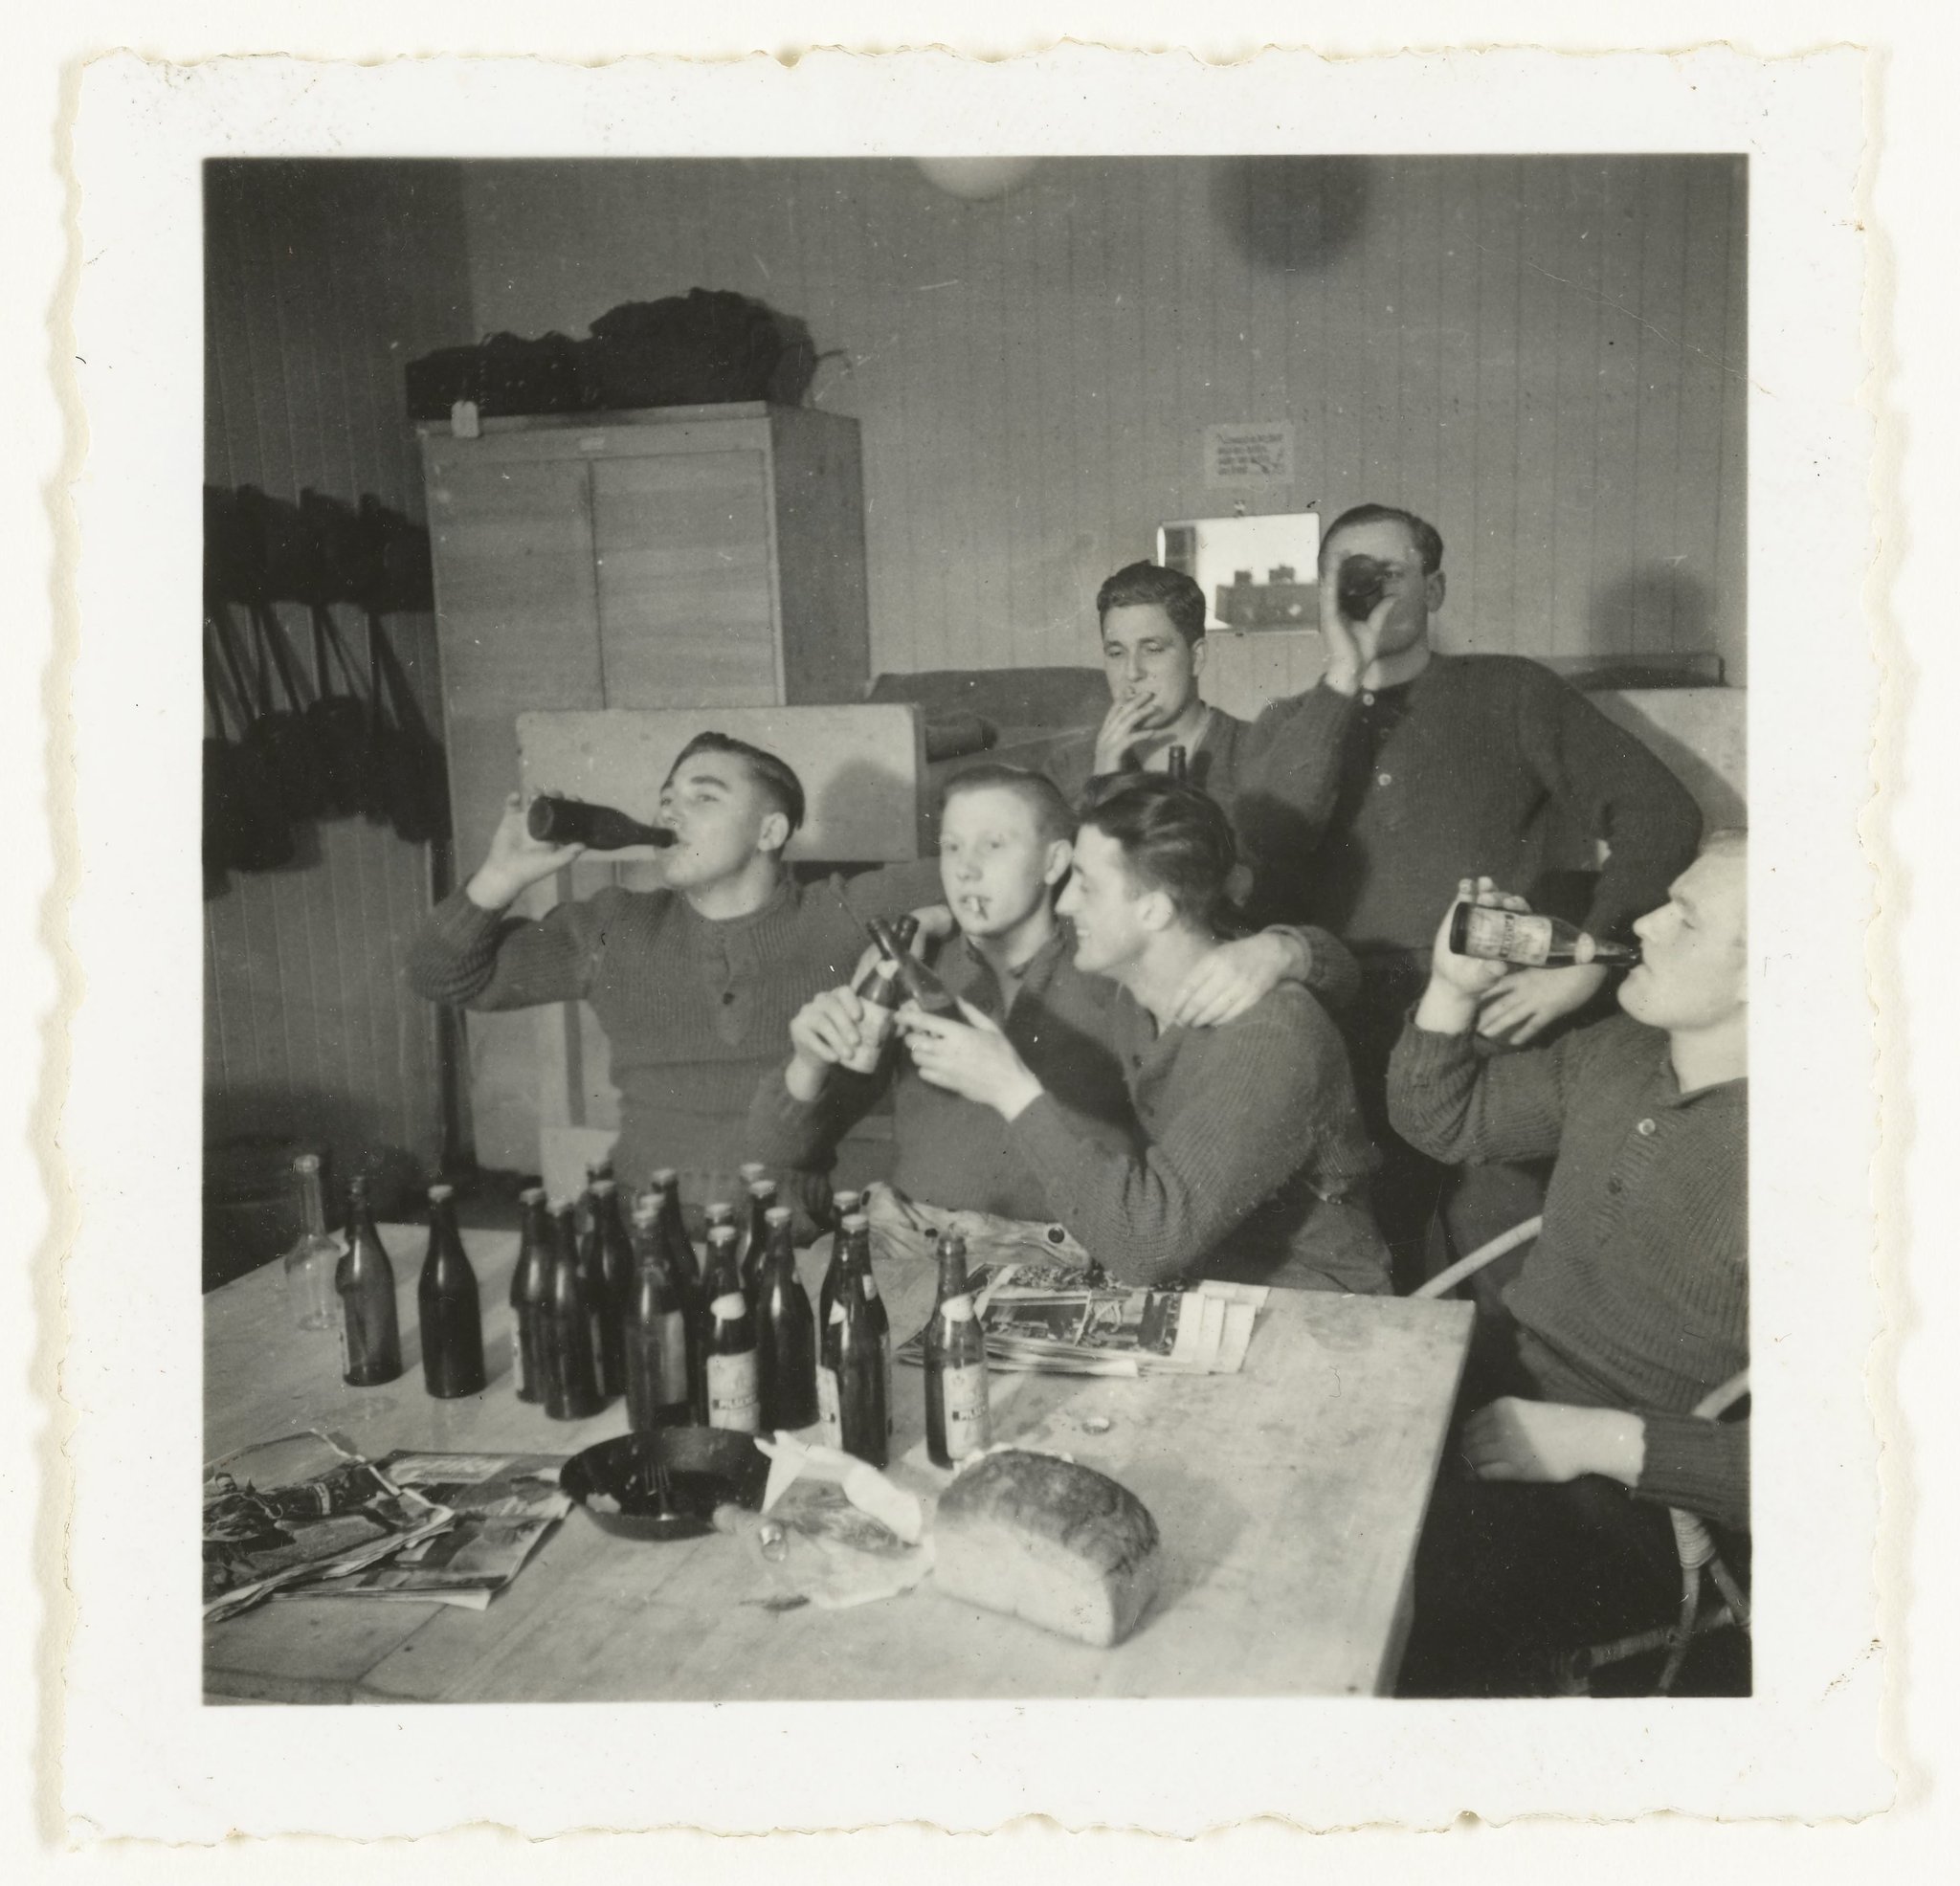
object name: photograph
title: Duitse soldaten vieren feest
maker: Anonymous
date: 1941-1942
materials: photographic support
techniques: gelatin silver print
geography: netherlands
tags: recreation ~ the soldier off duty, occupation ~ war, netherlands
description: Zes Wehrmacht soldaten vieren feest met veel flesjes bier. Op tafel ligt een brood en tijdschriften. Achterop staat: onleesbaar.